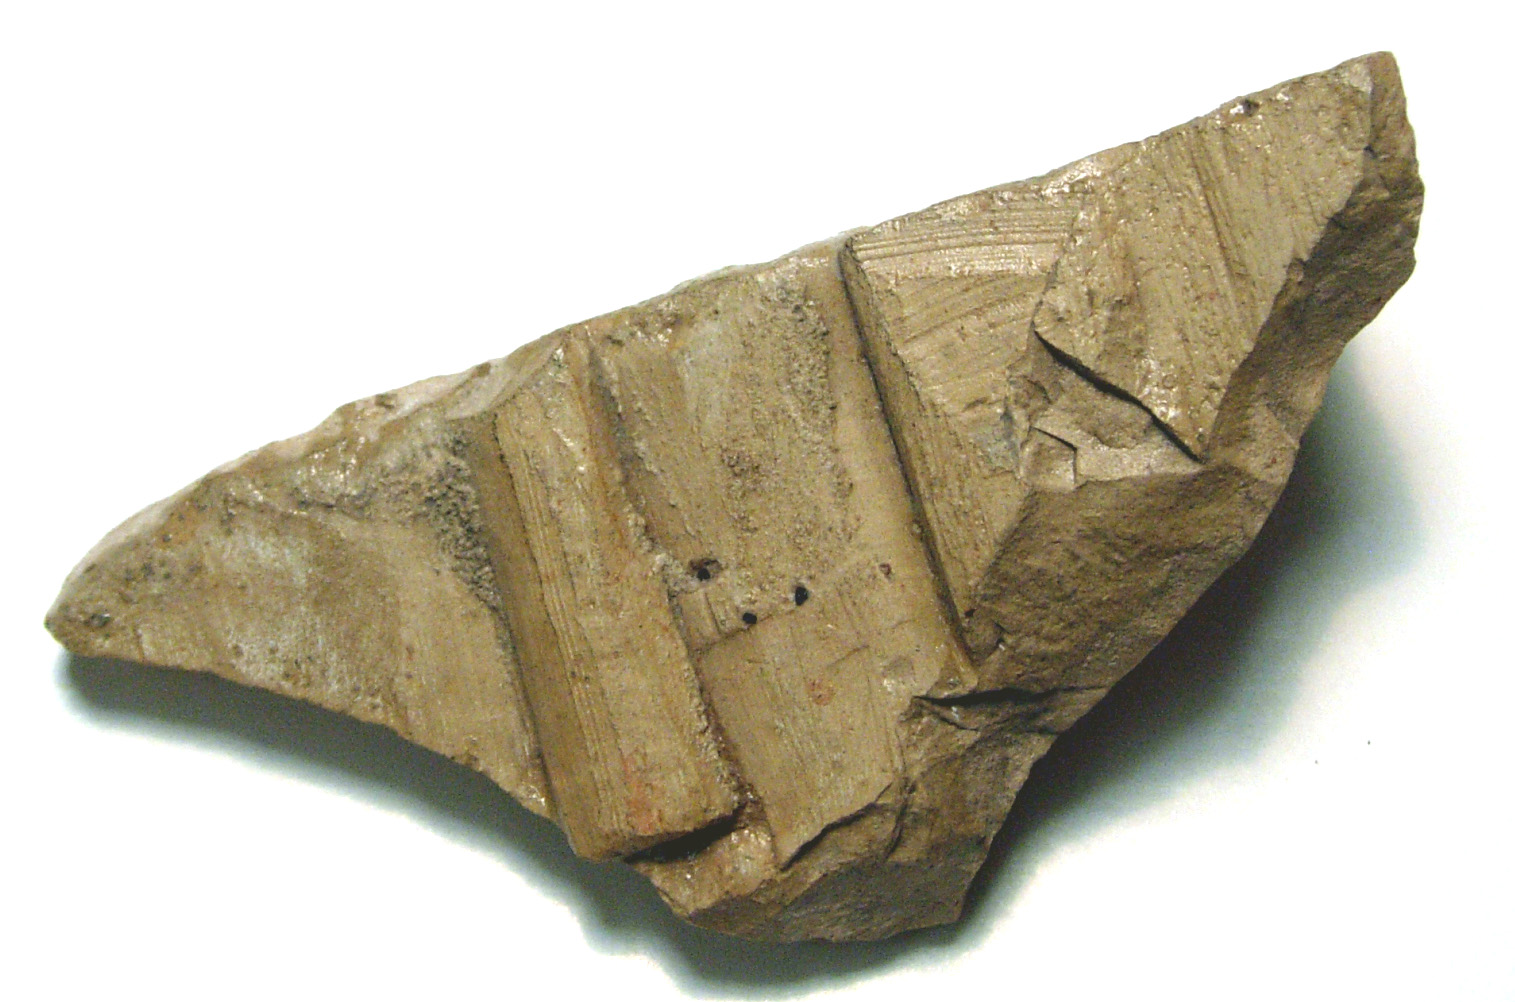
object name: relief, tomb of nespekashuty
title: Raised relief fragment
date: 664-610 BCE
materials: limestone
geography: egypt